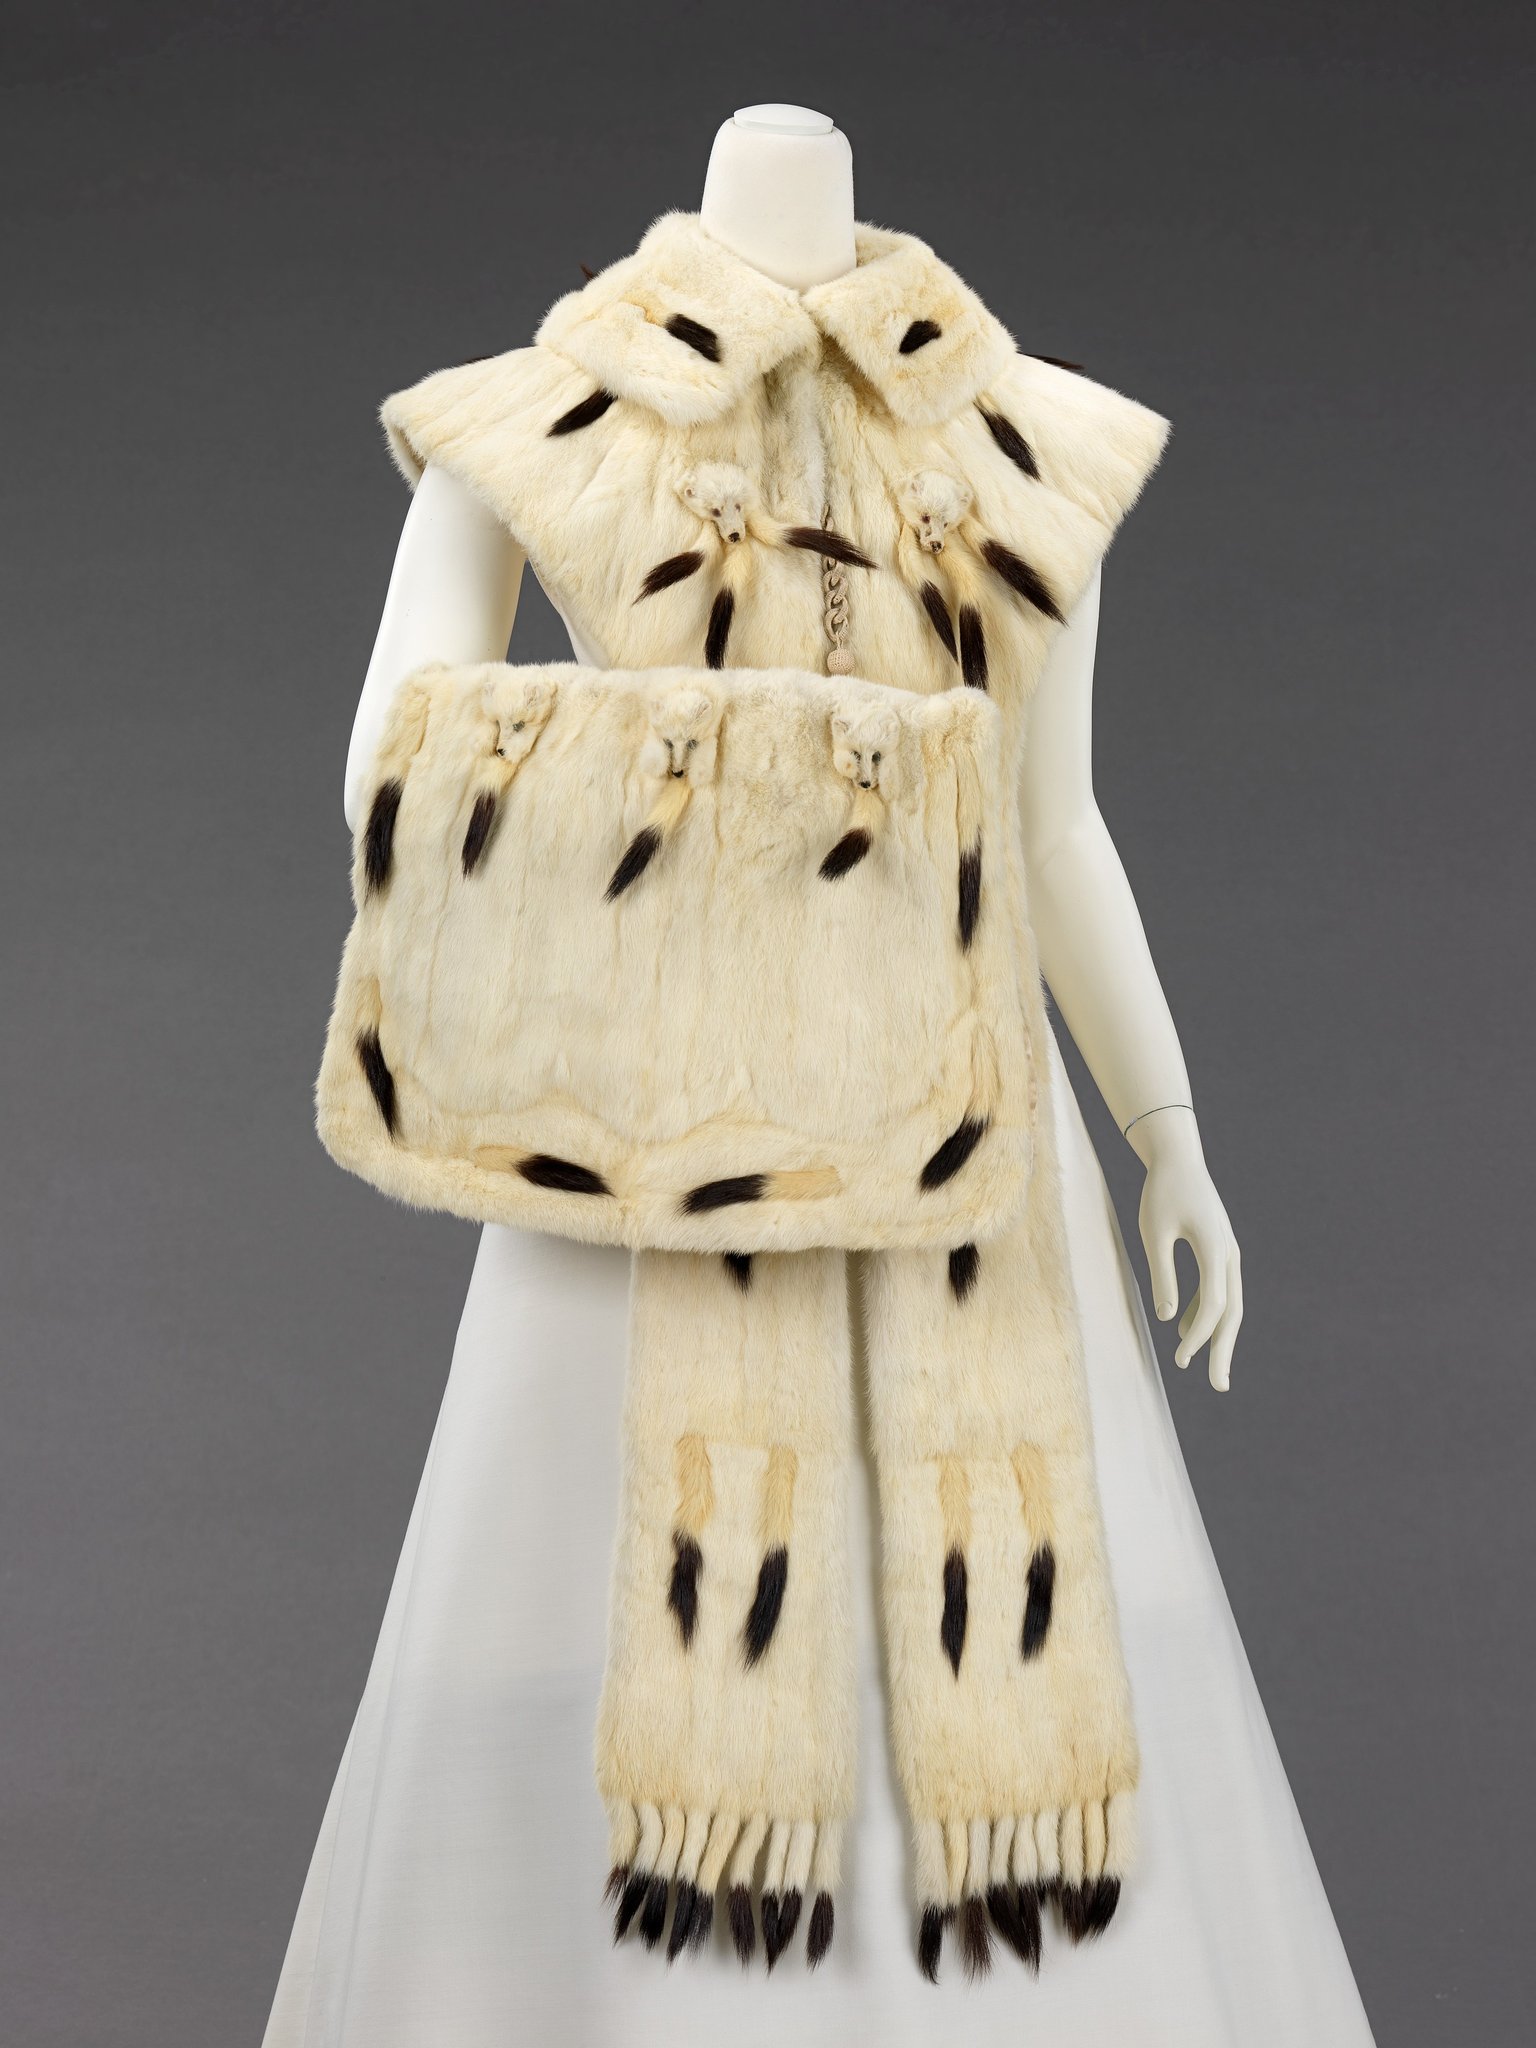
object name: accessory set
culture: american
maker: c. g. gunther's sons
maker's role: designer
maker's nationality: american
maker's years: 1820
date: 1890-1899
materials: fur, silk